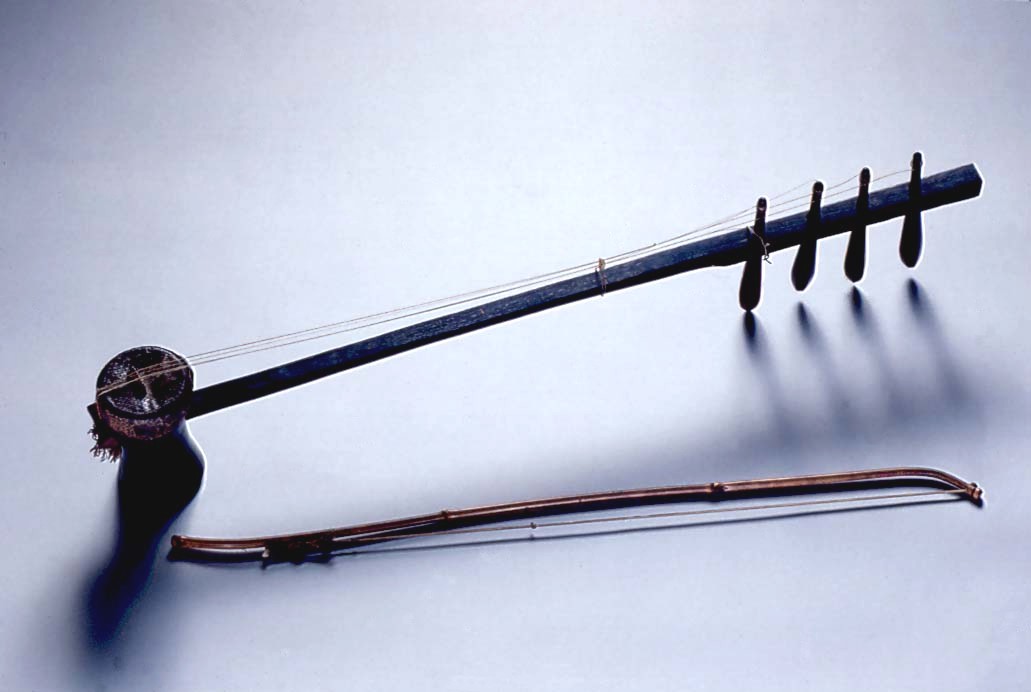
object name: kei kin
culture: japanese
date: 1801-1900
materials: skin, wood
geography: japan